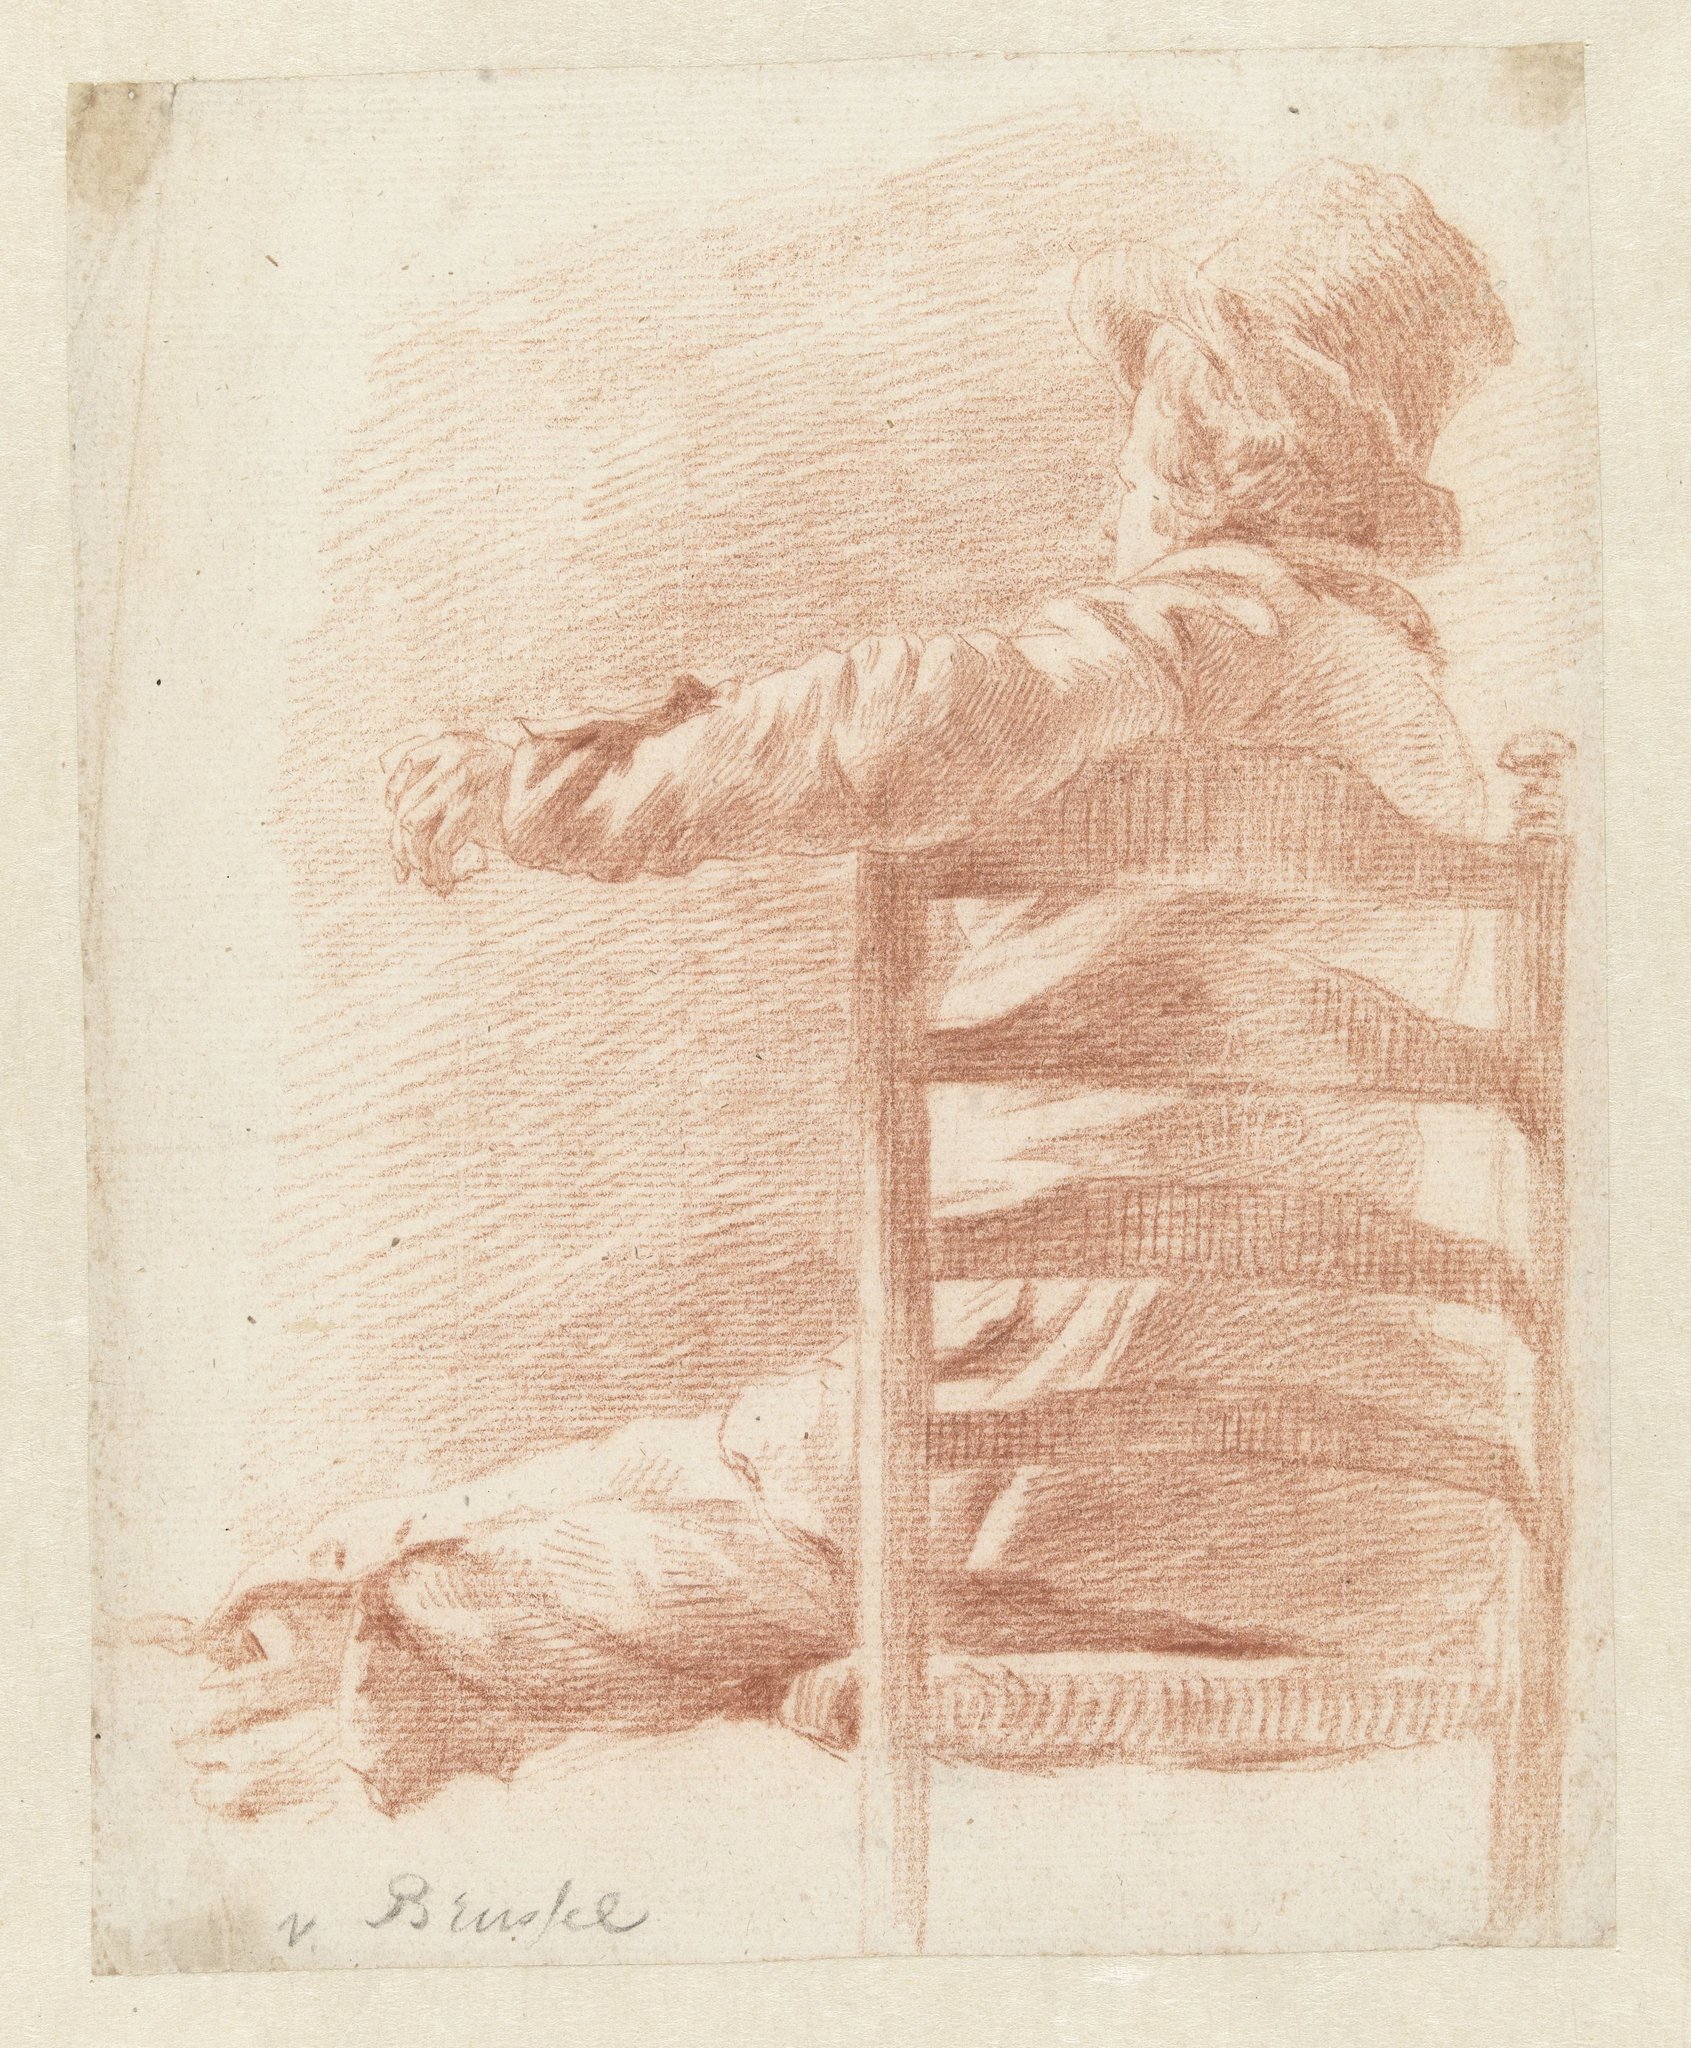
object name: drawing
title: Zittende man met hoed, ten halven lijve van achteren gezien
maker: hermanus van brussel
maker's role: draughtsman, print maker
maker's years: 1763-1815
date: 1773-1815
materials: chalk, paper